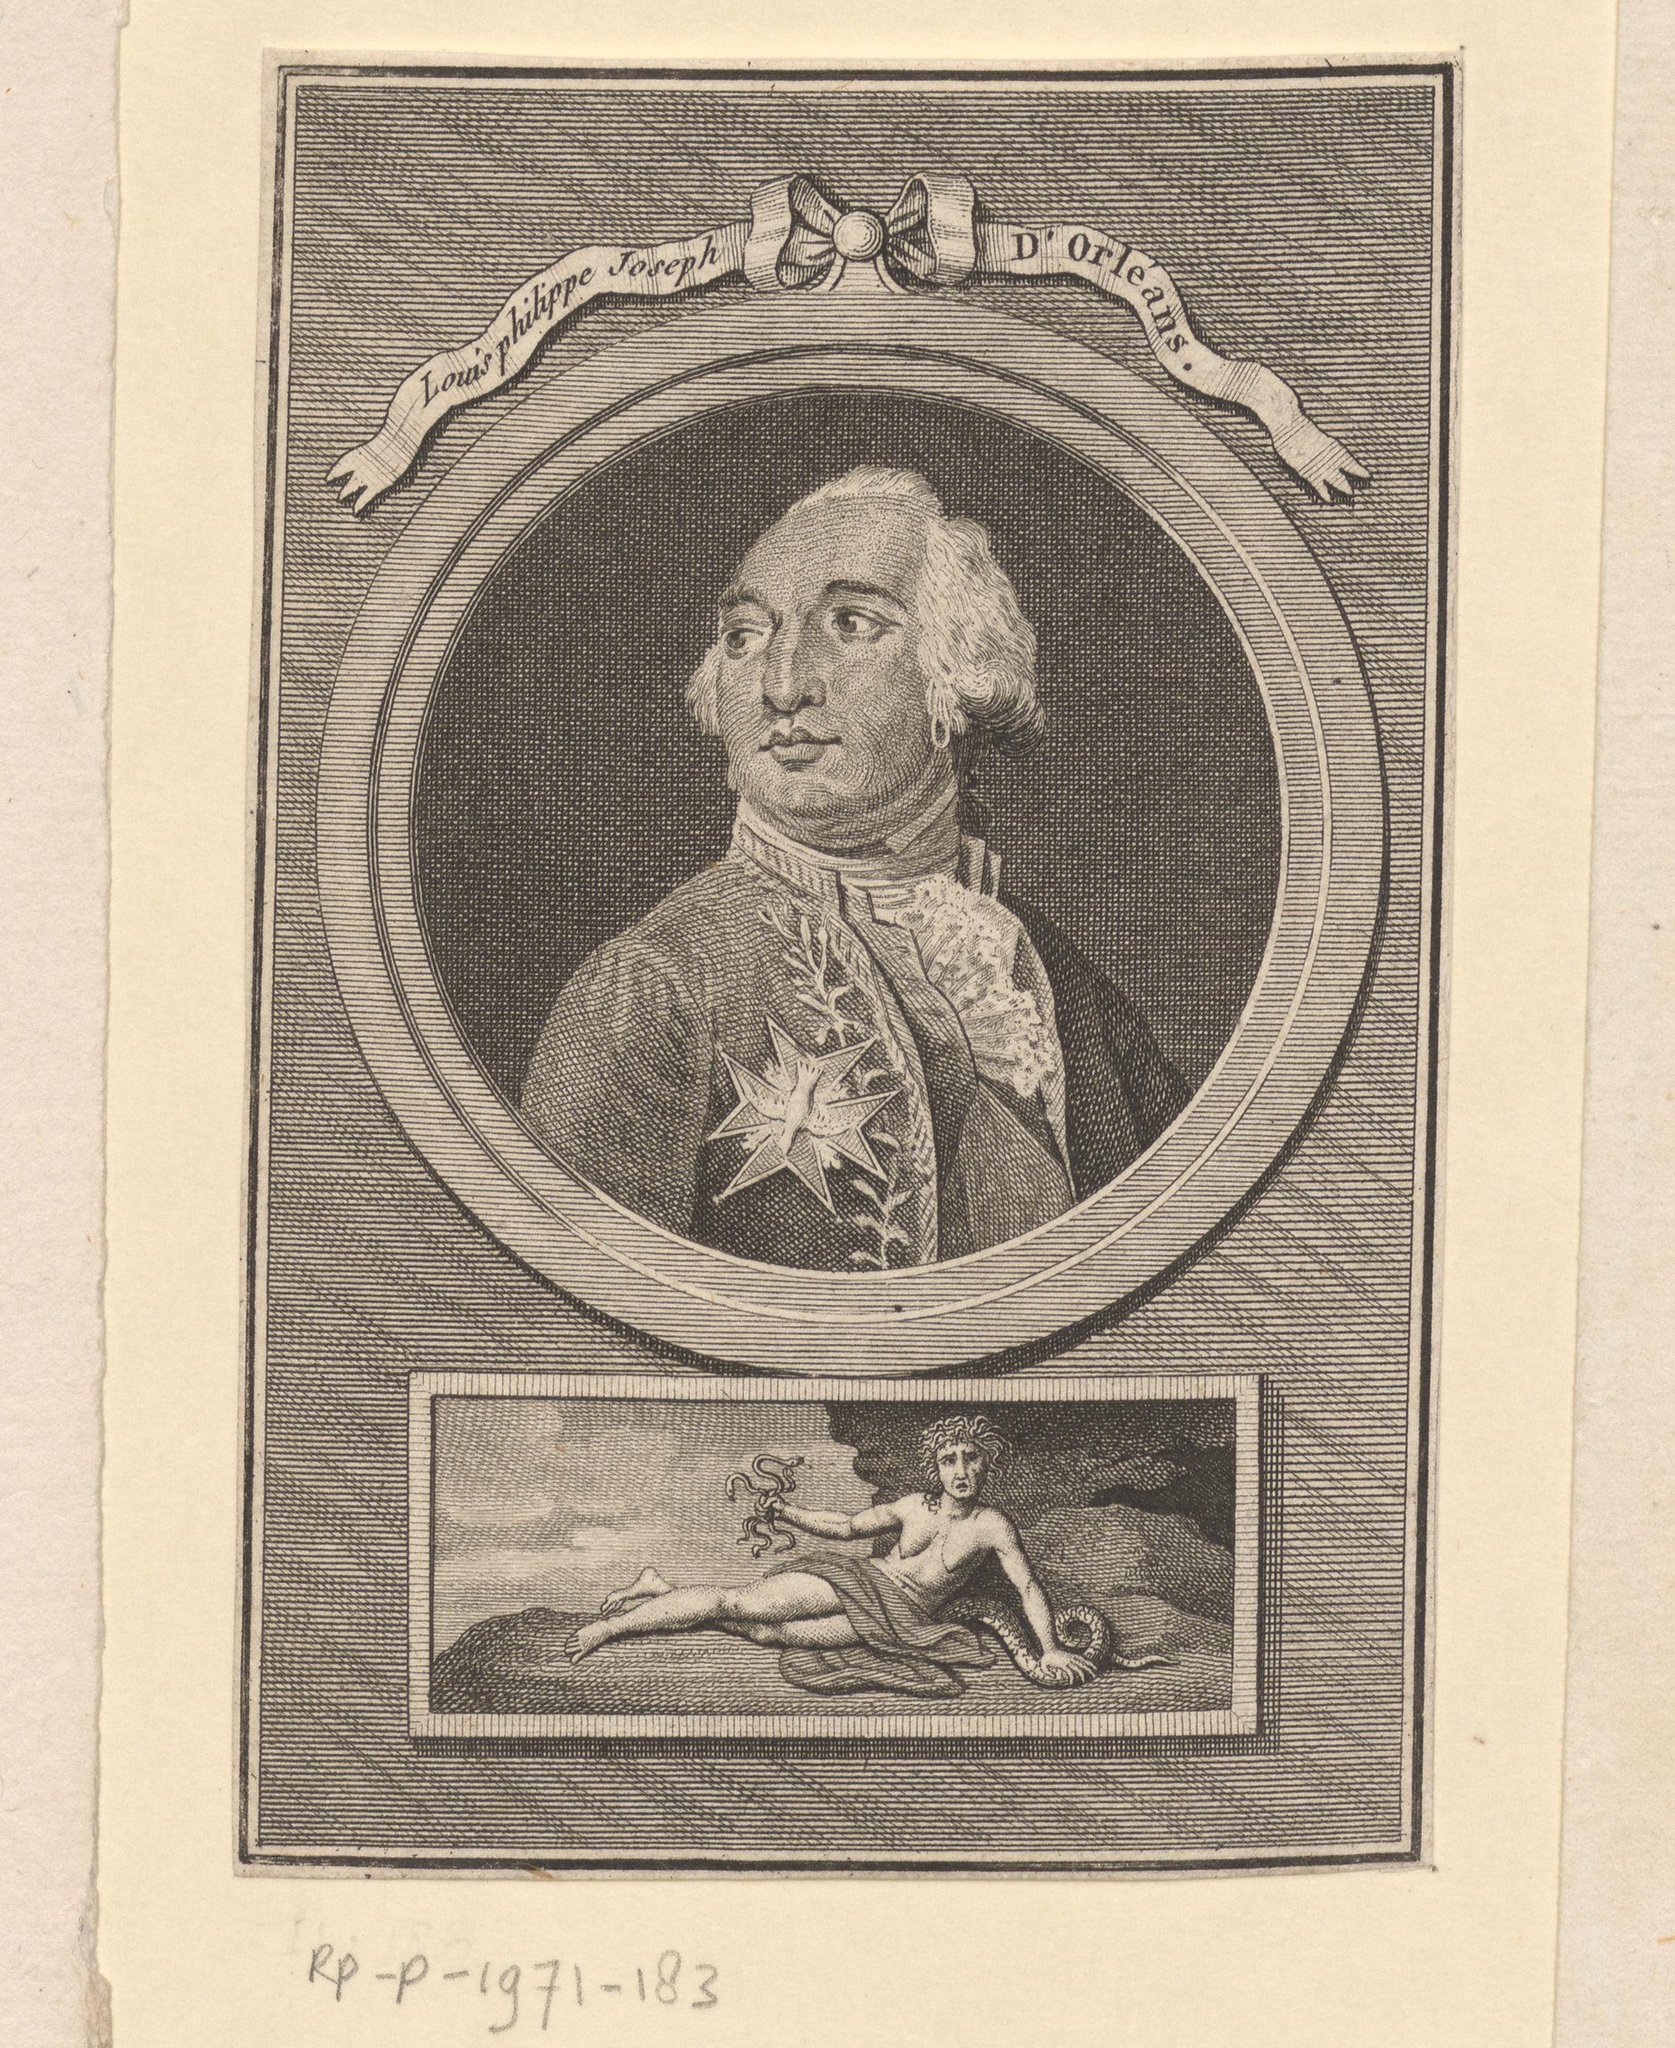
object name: print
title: Portret van Lodewijk Filips II van Orléans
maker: Anonymous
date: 1793-1799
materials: paper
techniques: etching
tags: paris, lodewijk filips ii (hertog van orléans), ornament ~ medallion, historical persons, medusa (one of the gorgons), ear-rings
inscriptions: collector's mark: Lugt 2228, collector's mark: Lugt 2760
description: Met onder het portret een voorstelling van Medusa, vermoedelijk verwijzend naar de Terreur.